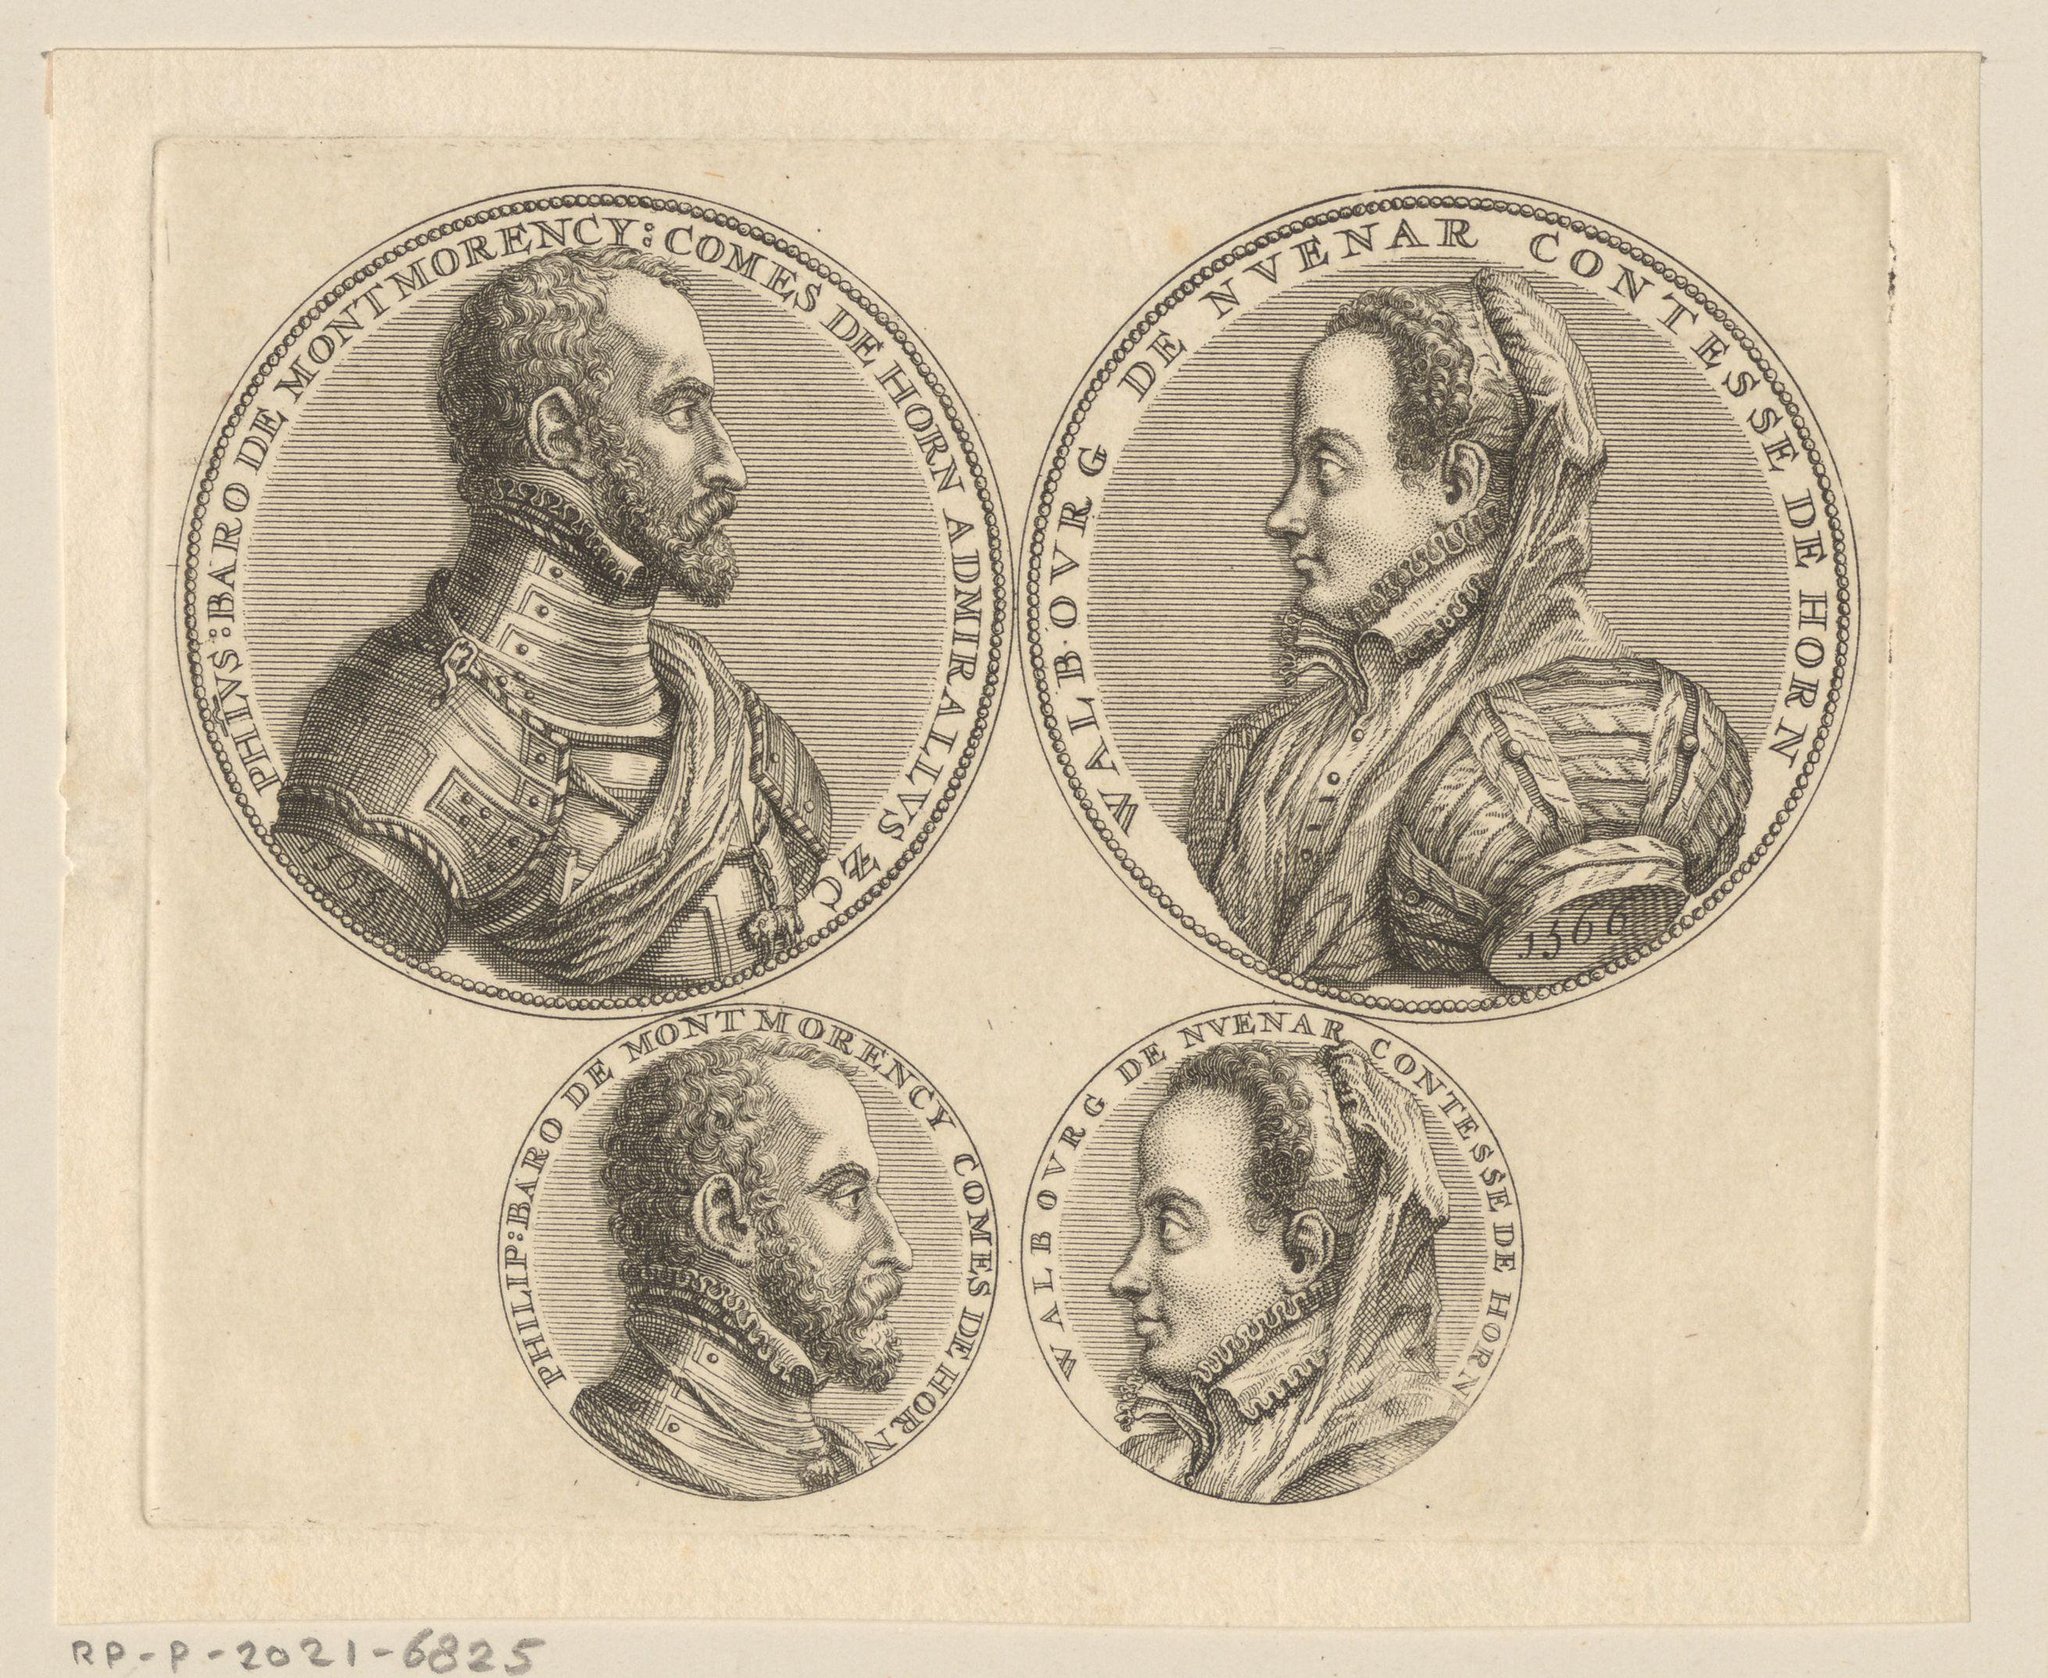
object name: print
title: Penning met portretten van Filips van Montmorency, graaf van Horne, en Walburgis van Nieuwenaar, gravin van Horne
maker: Anonymous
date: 1723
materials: paper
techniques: etching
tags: historical persons - bb - woman, armour, historical persons, knighthood order of the golden fleece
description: Prent met tekst op verso gebruikt in: Loon, Gerard van. Beschryving der Nederlandsche historipenningen (...). Den Haag: Christiaan van Lom, Isaac Vaillant, Pierre Gosse, Rutgert Christoffel Alberts en Pieter de Hondt, 1723, dl. 1, p. 76.